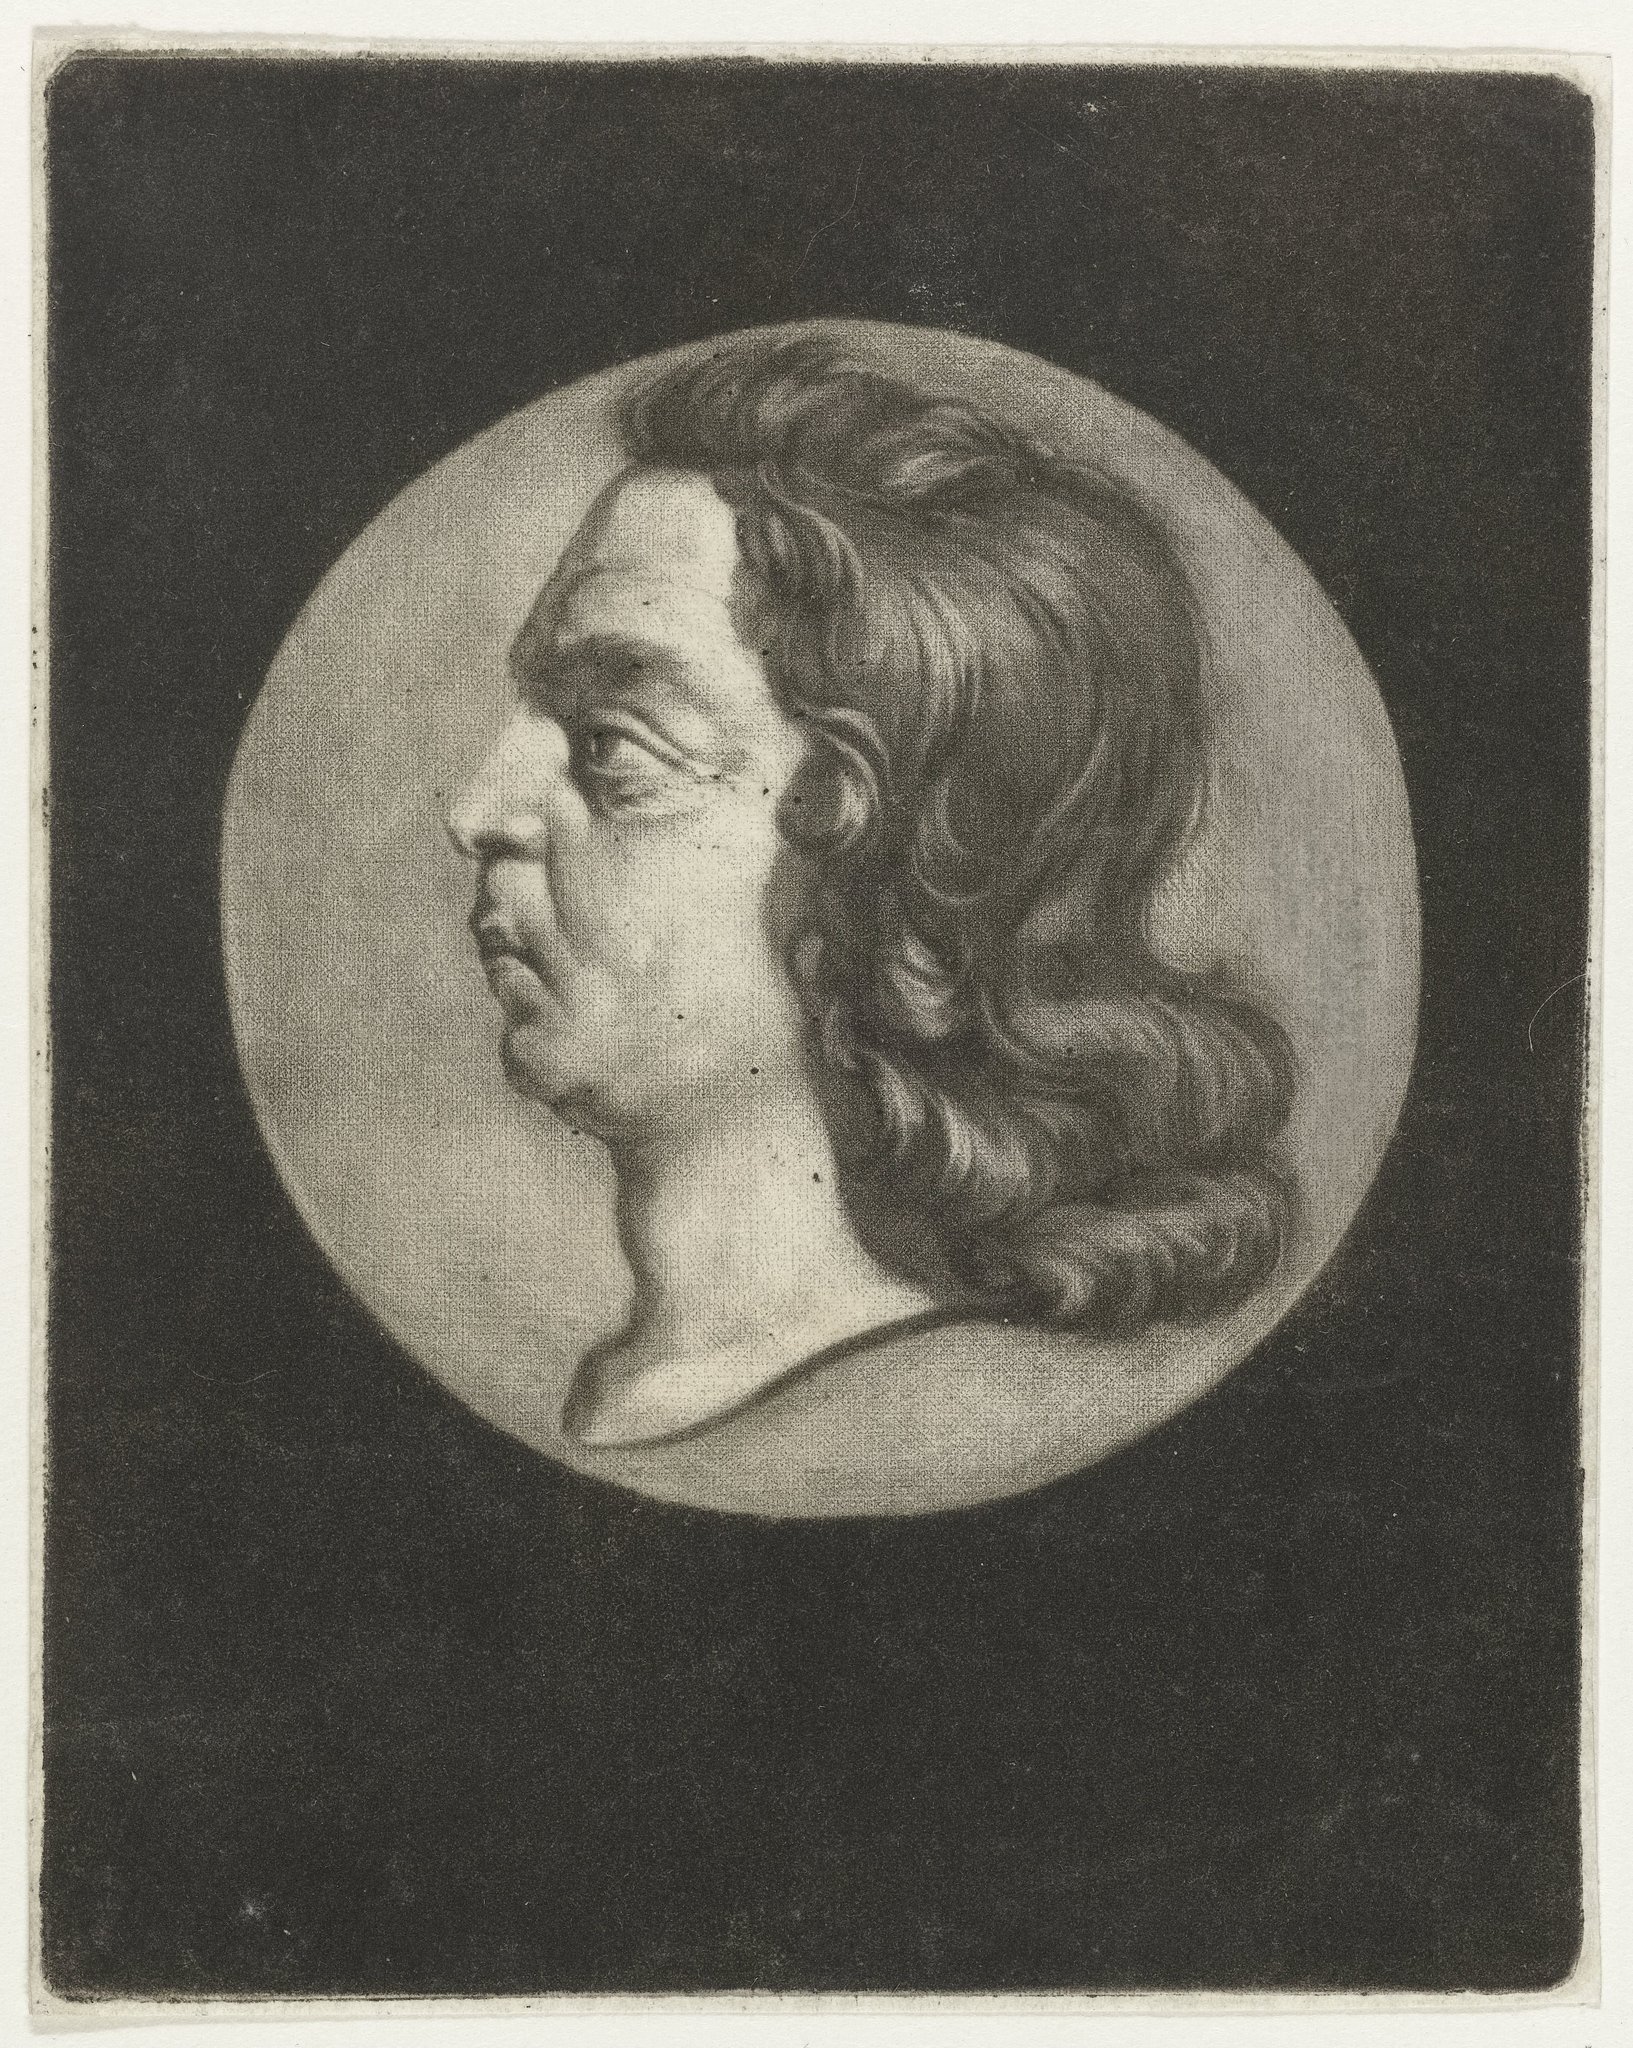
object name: print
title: Portret van Hendricks Haecks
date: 1683-1746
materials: paper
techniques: mezzotint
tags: koopman, hendricks haecks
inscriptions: collector's mark: Lugt 2228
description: De Duitse koopman Hendricks Haecks, in profiel.